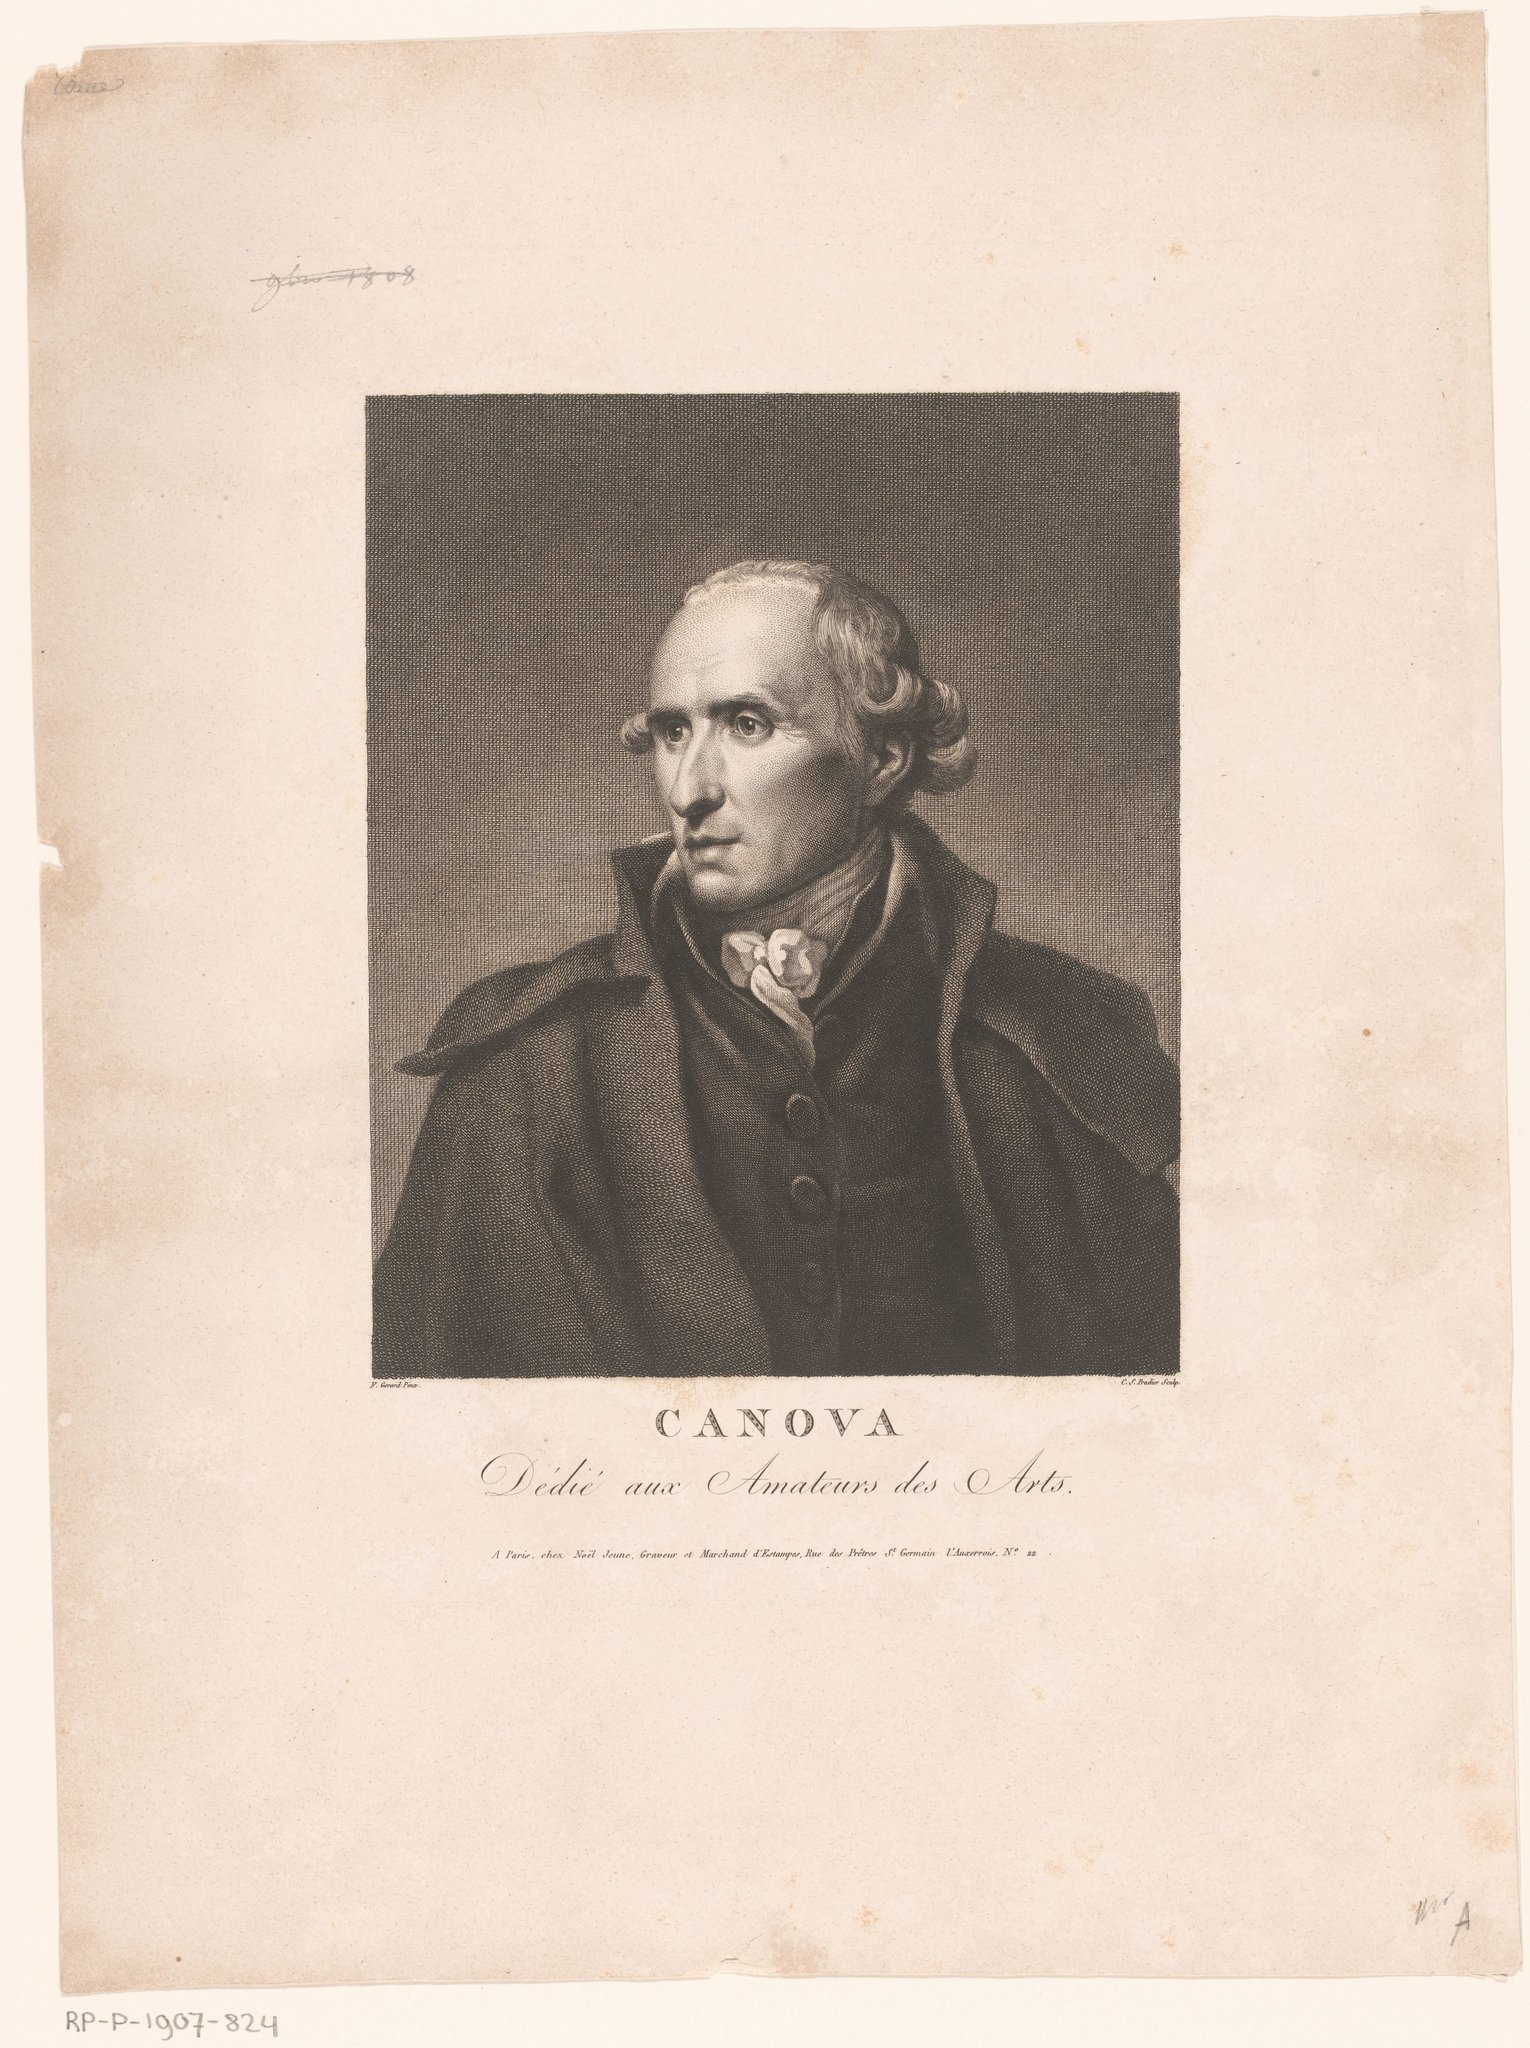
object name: print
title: Portret van Antonio Canova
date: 1810-1820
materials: paper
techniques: engraving, etching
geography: paris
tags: venice, painter, antonio canova, portrait, self-portrait of sculptor, historical persons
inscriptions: collector's mark: Lugt 2228